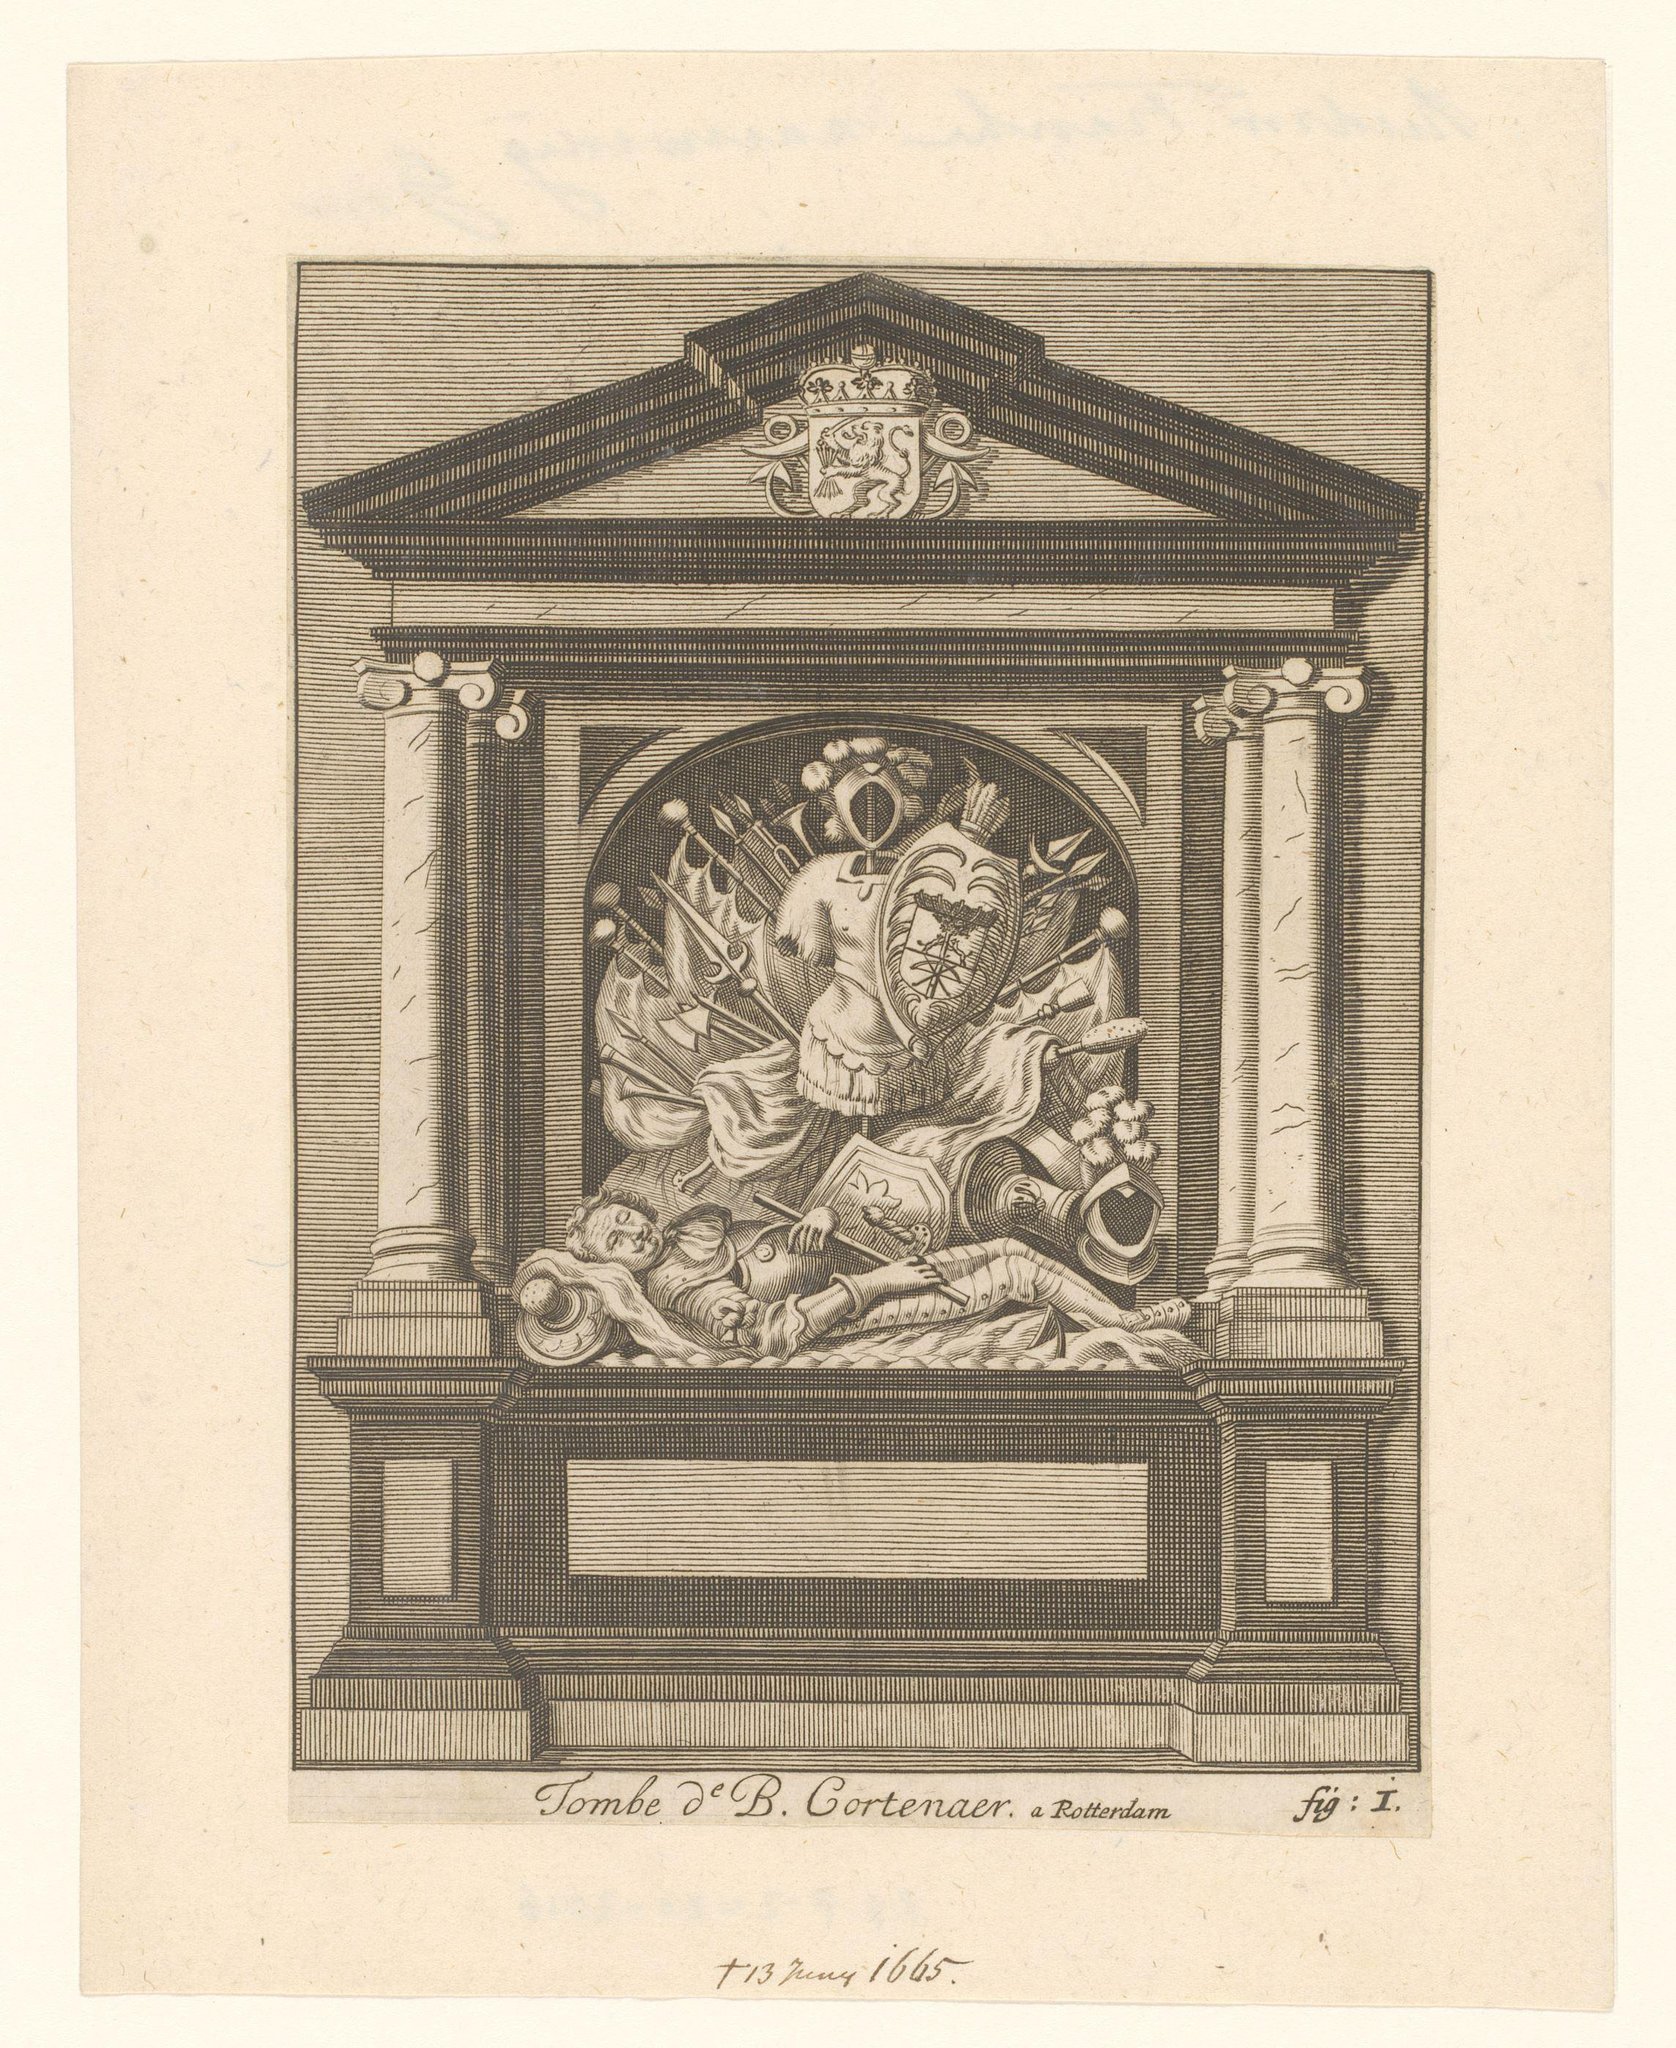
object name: print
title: Grafmonument van Egbert Meeusz Kortenaer te Rotterdam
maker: Anonymous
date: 1690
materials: paper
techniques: engraving, etching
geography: northern netherlands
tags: helmet, protective weapons: shield, coat of arms (as symbol of the state, etc.) (+ nation; national), armour, historical persons, casting weapons: spear, grave, tomb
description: Prent waarschijnlijk uit: Bizot, Pierre. Medalische historie der republyk van Holland. Amsterdam: Pieter Mortier, 1690.